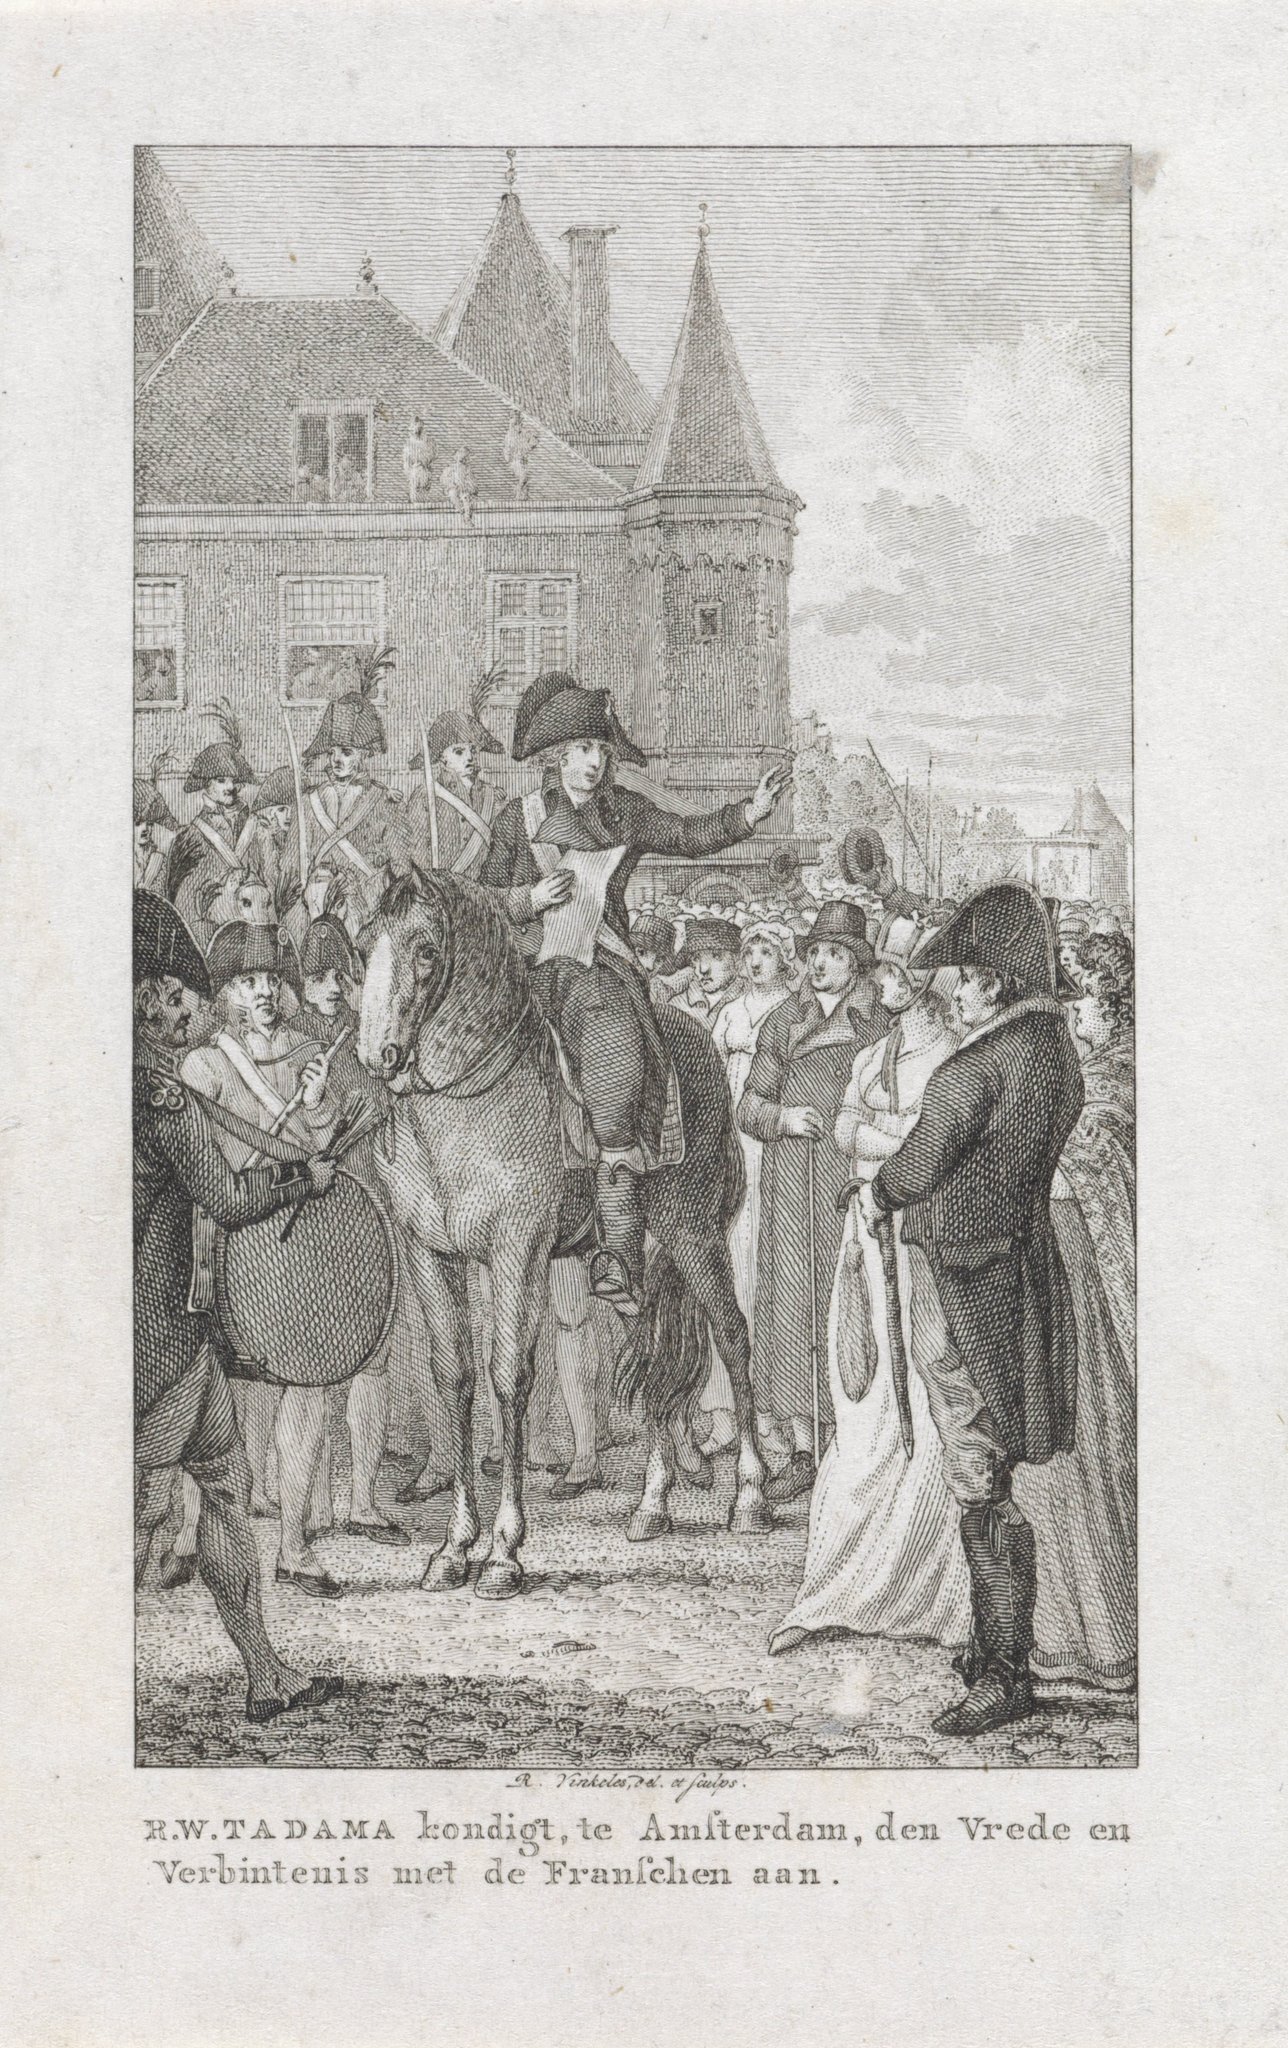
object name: print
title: Tadama maakt de alliantie met Frankrijk bekend, 1795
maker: reinier vinkeles (i)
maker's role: draughtsman, print maker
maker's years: 1741-1816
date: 1801-1803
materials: paper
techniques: engraving, etching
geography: northern netherlands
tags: amsterdam, announcement, proclamation of laws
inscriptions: collector's mark: Lugt 2166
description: Gebruikt als illustratie in: P.A. Loosjes. Vaderlandsche historie, vervattende de geschiedenissen, der Vereenigde Nederlanden (...). Ten onmiddelyken vervolge van Wagenaar's Vaderlandsche historie. Amsterdam: Johannes Allart, dl. 30 (1803).